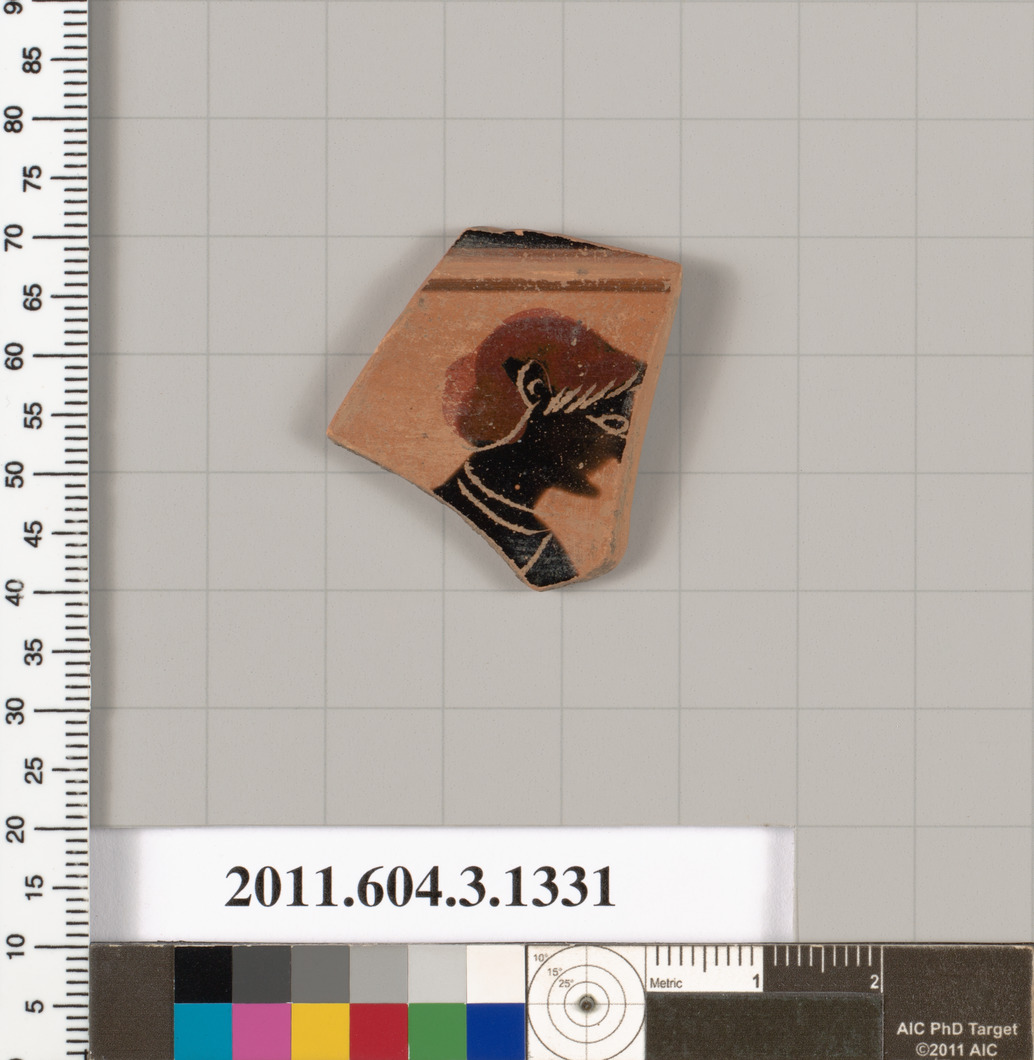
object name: skyphos fragment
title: Terracotta fragment of a skyphos (deep drinking cup)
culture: greek, attic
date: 534-468 BCE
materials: terracotta